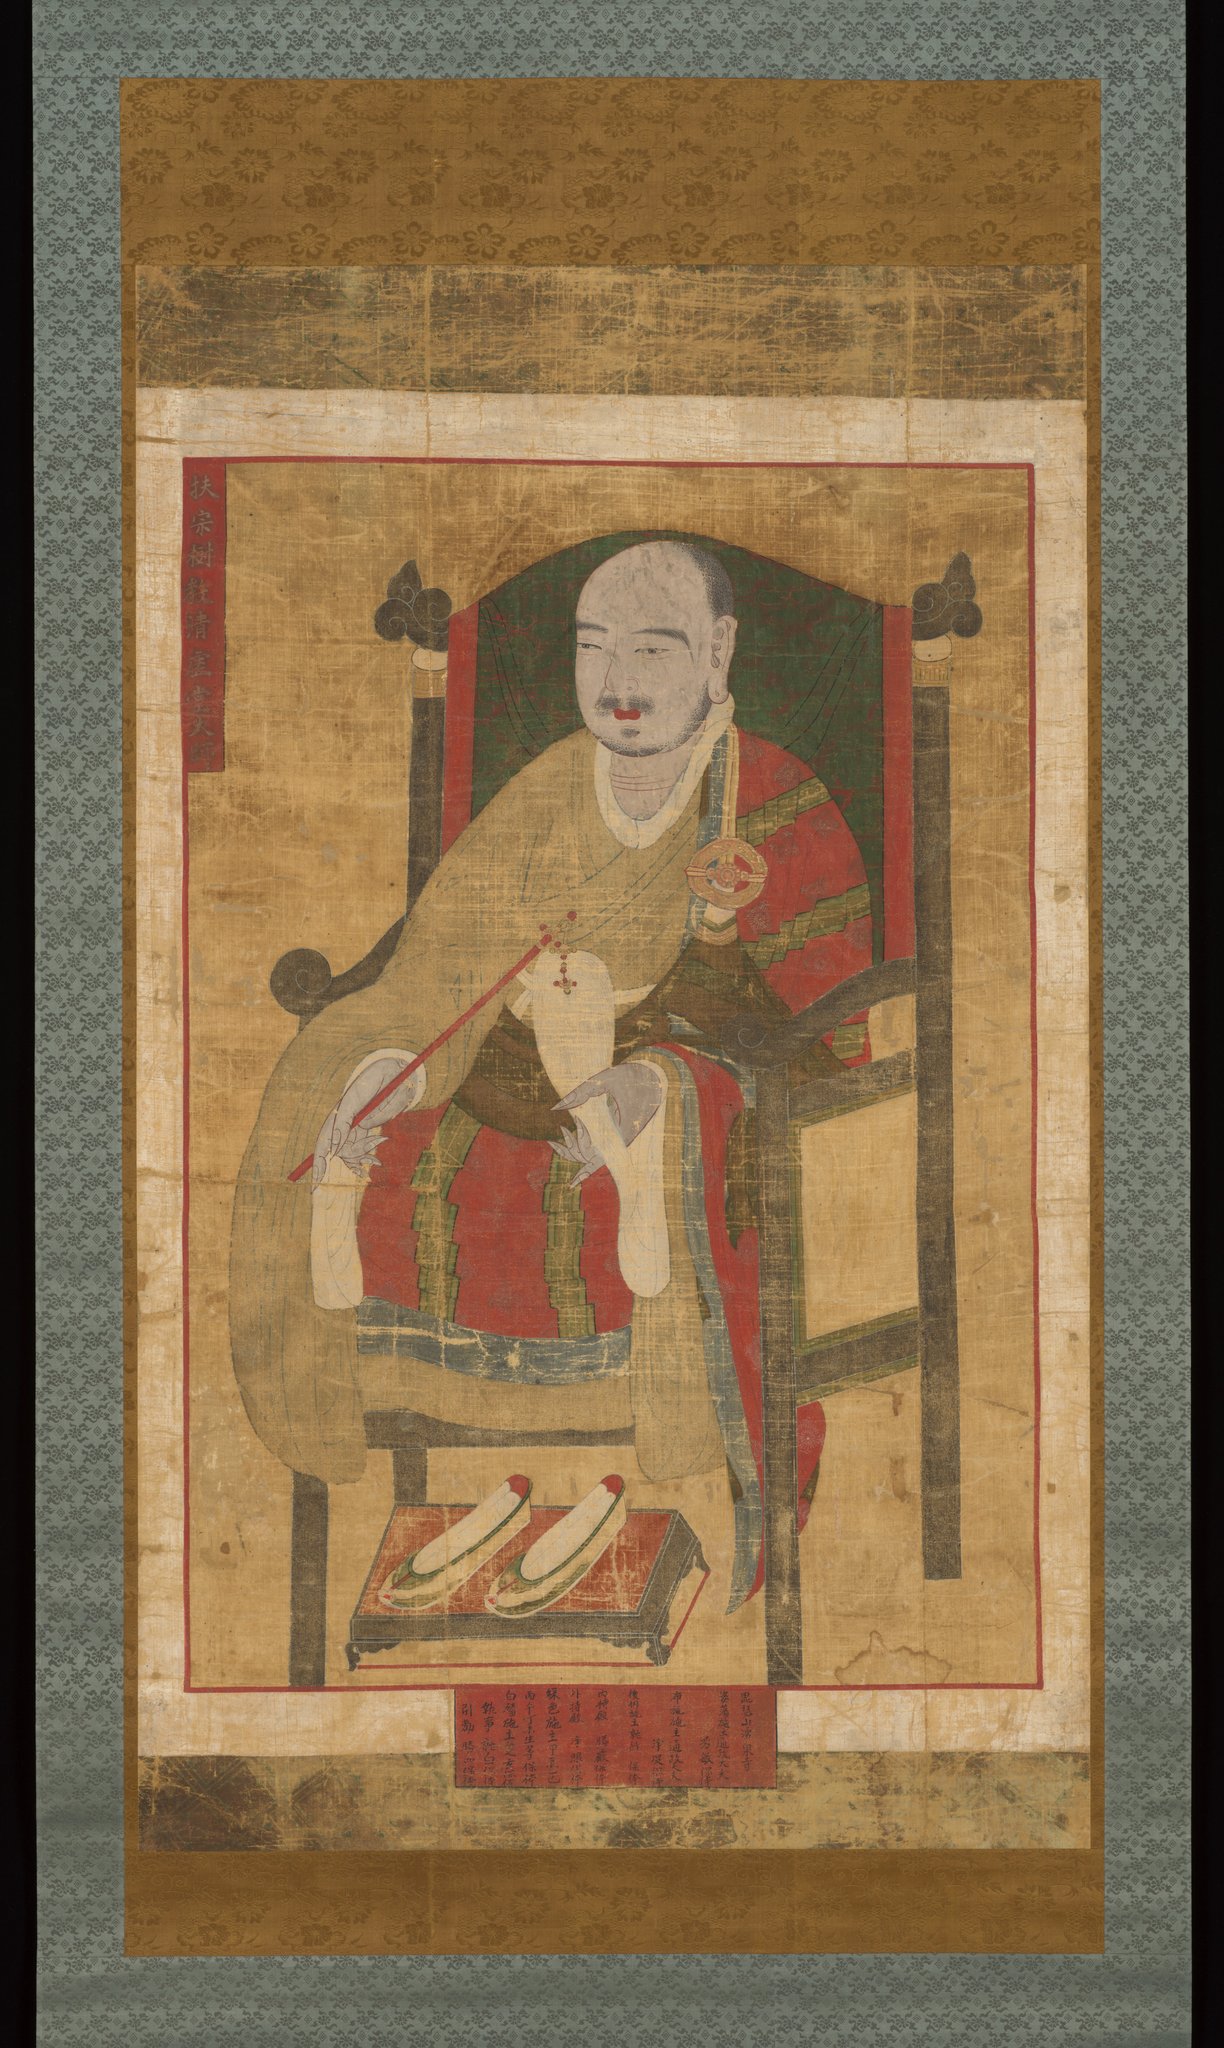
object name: hanging scroll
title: Portrait of the Great Master Seosan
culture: korean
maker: unidentified artist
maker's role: artist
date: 1667-1800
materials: ink, silk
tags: shoes,men,portraits,chairs